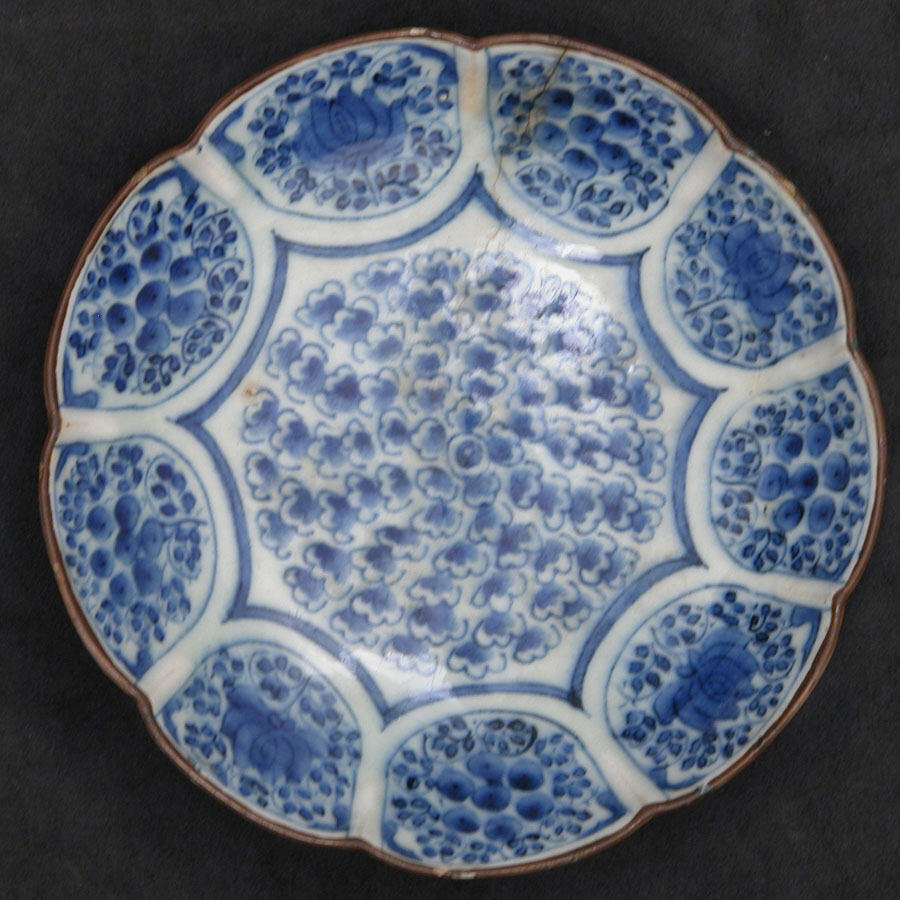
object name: dish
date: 1601-1700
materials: earthenware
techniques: glazing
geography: iran